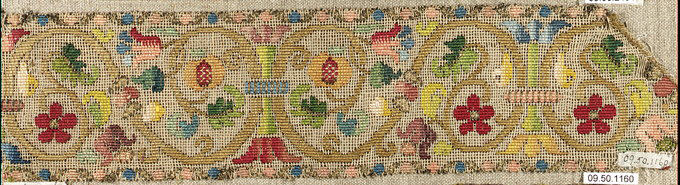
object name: strip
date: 1601-1700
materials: silk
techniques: embroidery